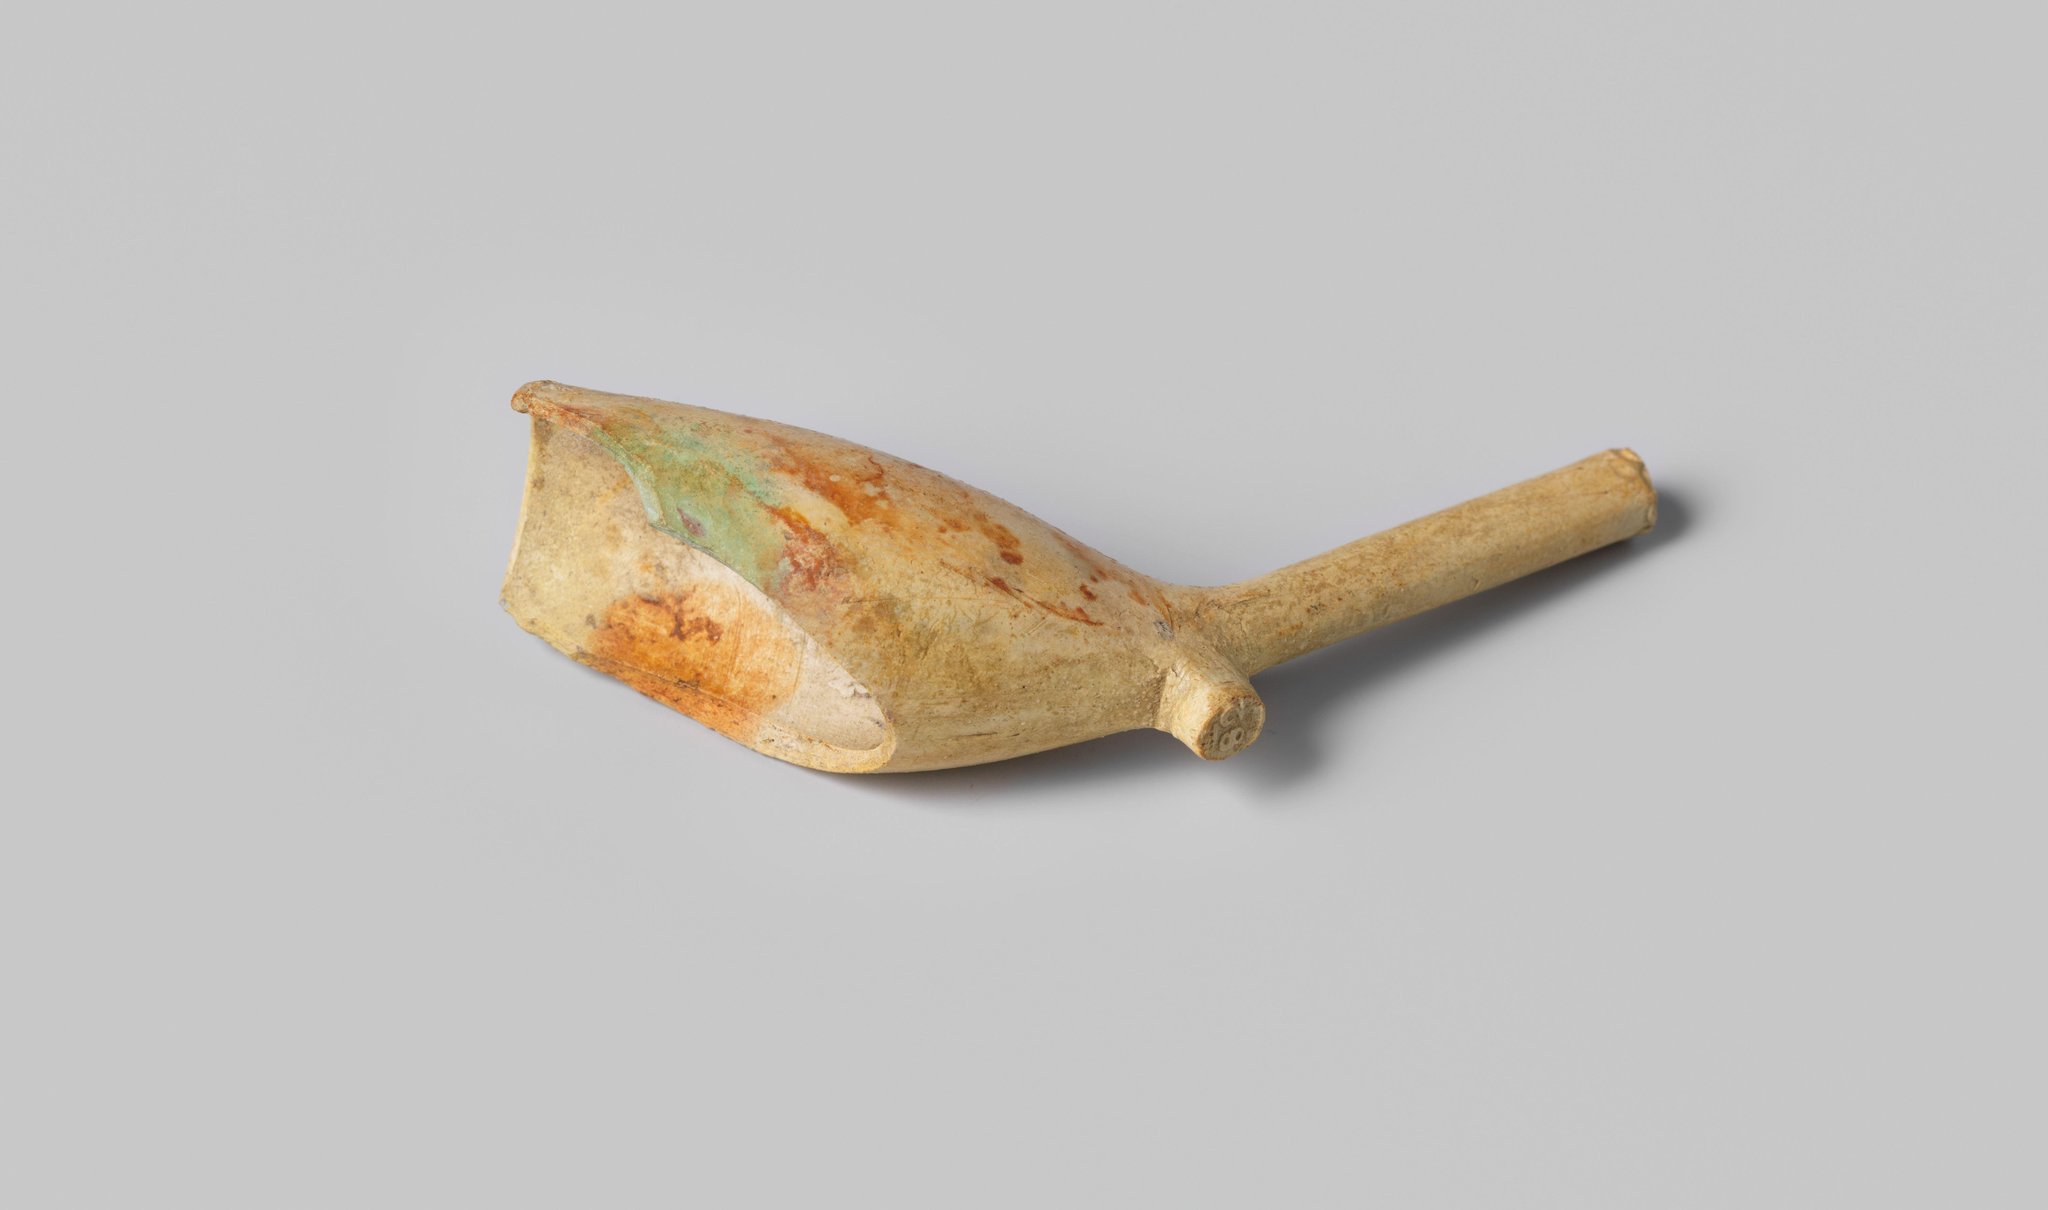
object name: fragment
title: Fragment pijp uit het wrak van de Oost-Indiëvaarder Hollandia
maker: Anonymous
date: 1700-1743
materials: clay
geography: netherlands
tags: verenigde oostindische compagnie, hollandia (schip), annet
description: Pipe, bowl, heelmark: crowned 82; fragment, no hsm.